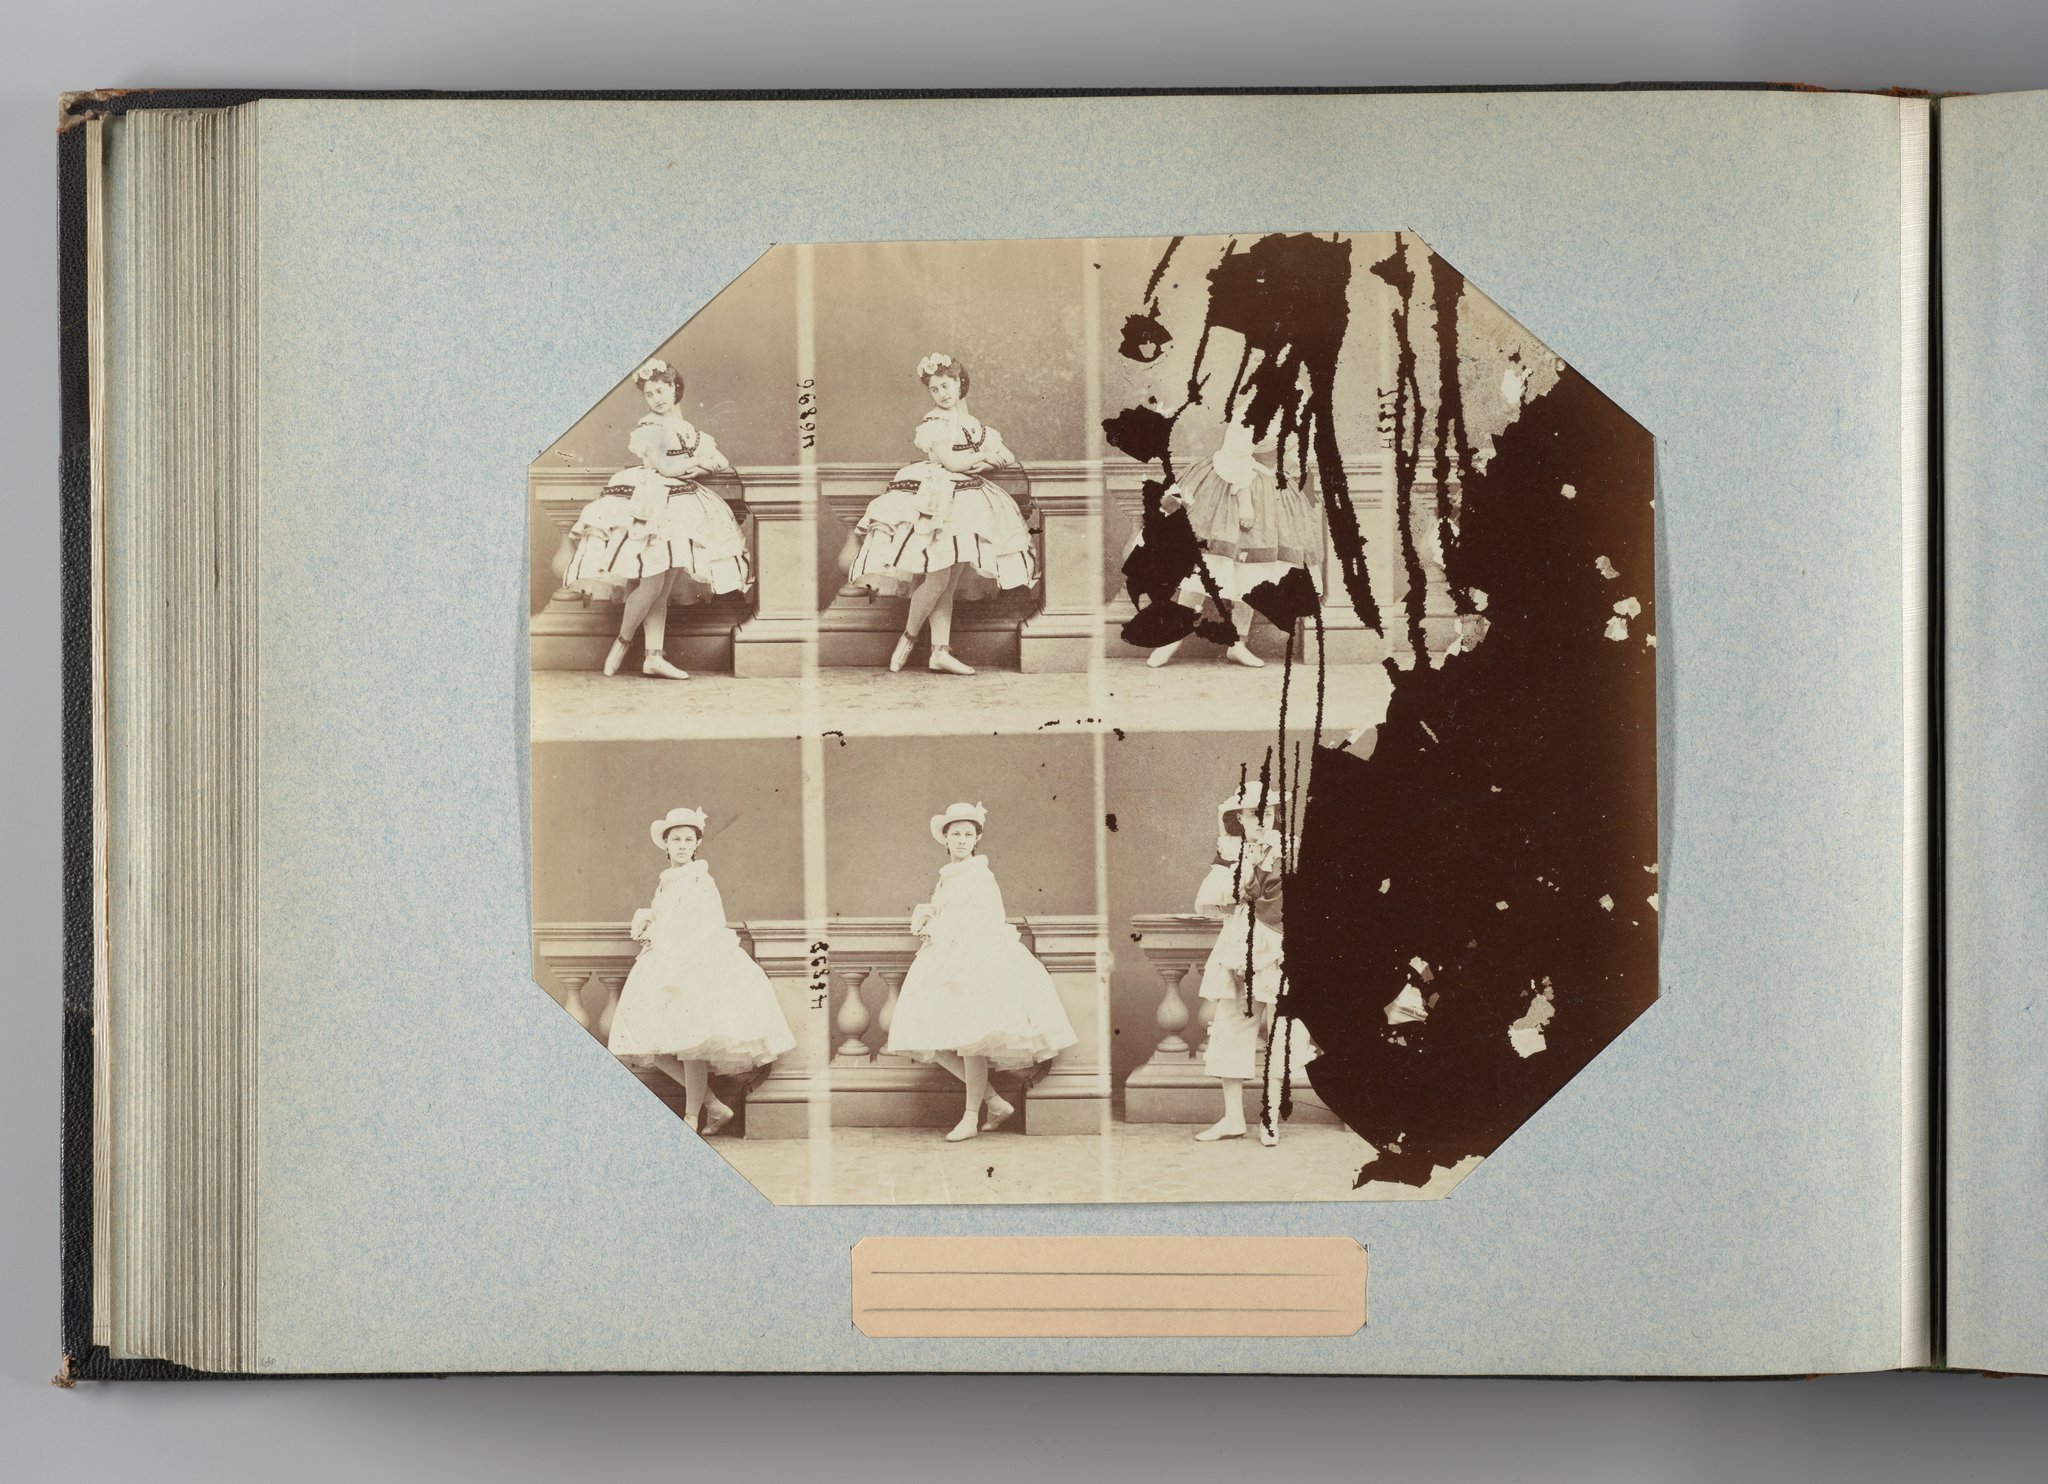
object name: photograph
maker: andré-adolphe-eugène disdéri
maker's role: artist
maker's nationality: french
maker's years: 1819-1889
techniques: albumen silver print, glass negative